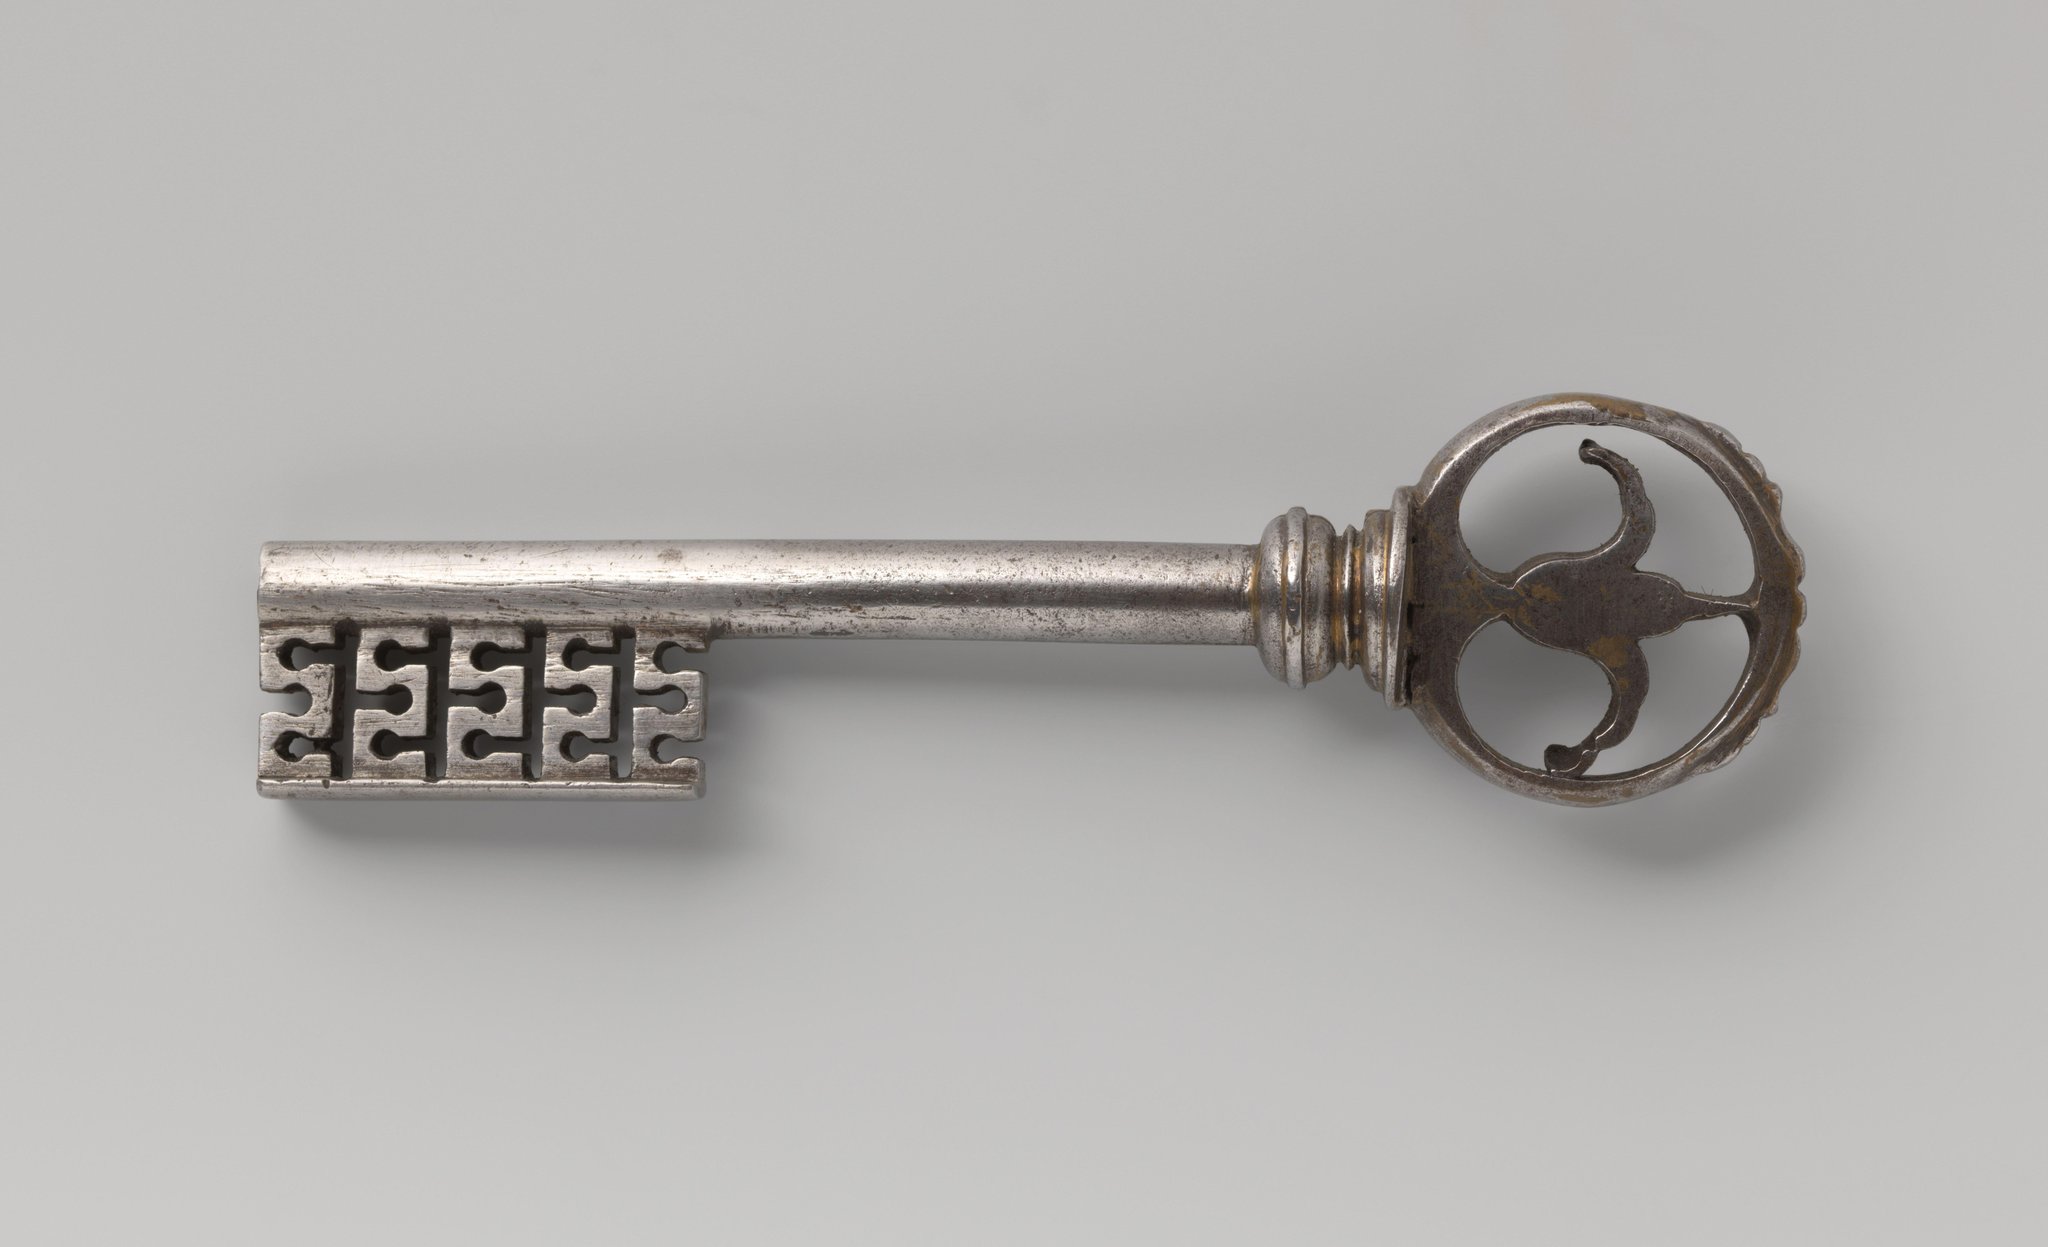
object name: key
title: Sleutel, behorend bij kunstslot van ijzer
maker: Anonymous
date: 1600-1699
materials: iron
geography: netherlands